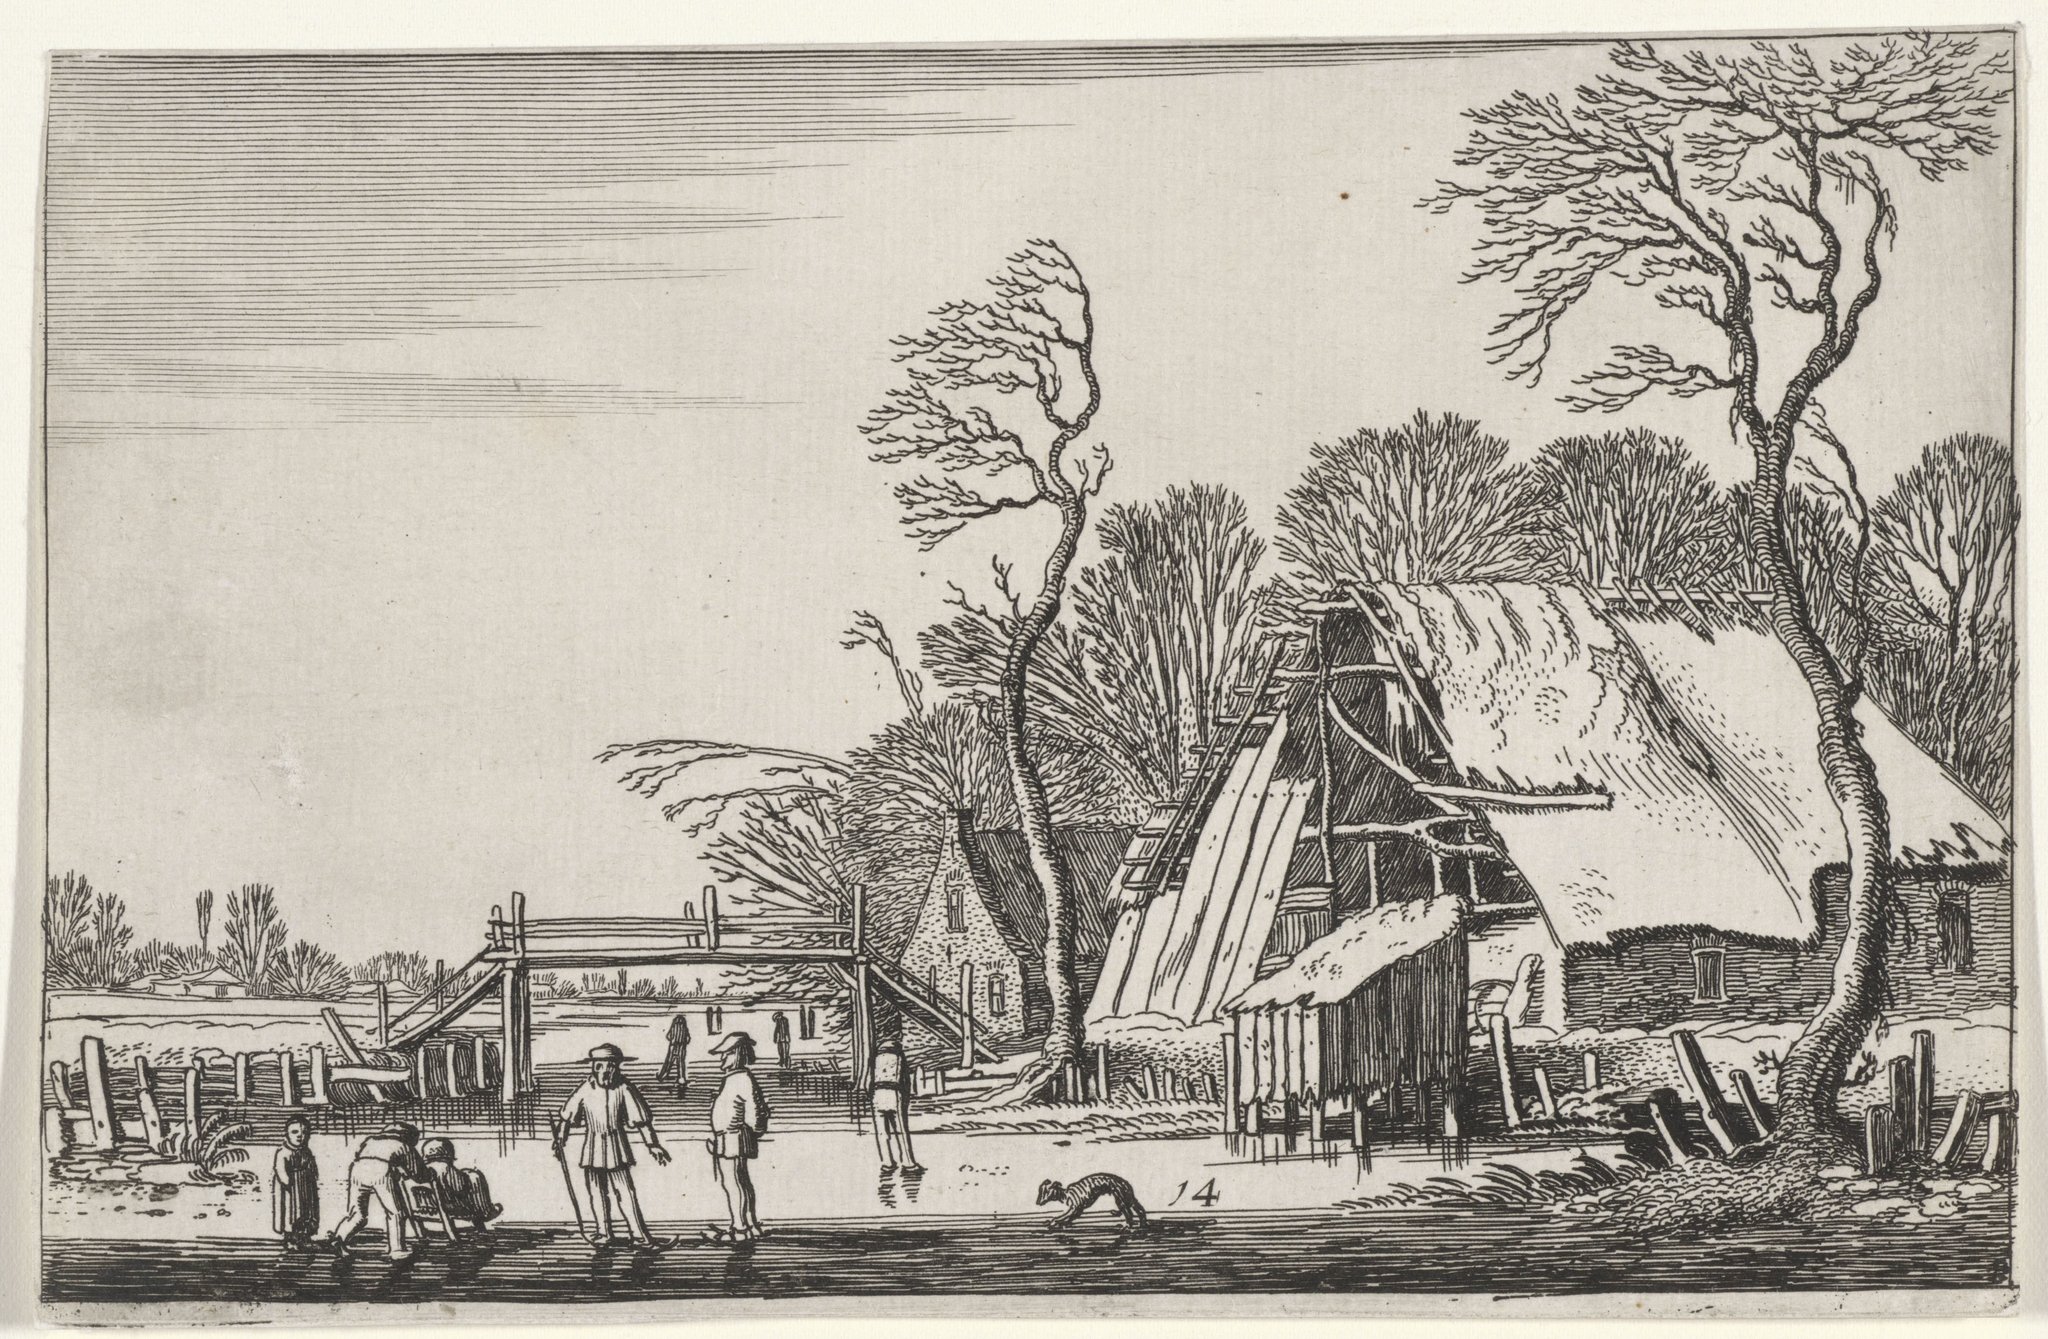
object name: print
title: Ruïnes in landschappen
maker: jan van de velde (ii)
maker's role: draughtsman, painter, print maker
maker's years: 1593-1641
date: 1616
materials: paper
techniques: etching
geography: northern netherlands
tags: bridges by construction, skates (winter sports), ruin of a dwelling, house, castle, etc.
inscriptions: collector's mark: Lugt 964, collector's mark: Lugt 698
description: Figuren op het ijs bij een vervallen boerderij en een houten brug. Veertiende prent uit een serie van zestien.